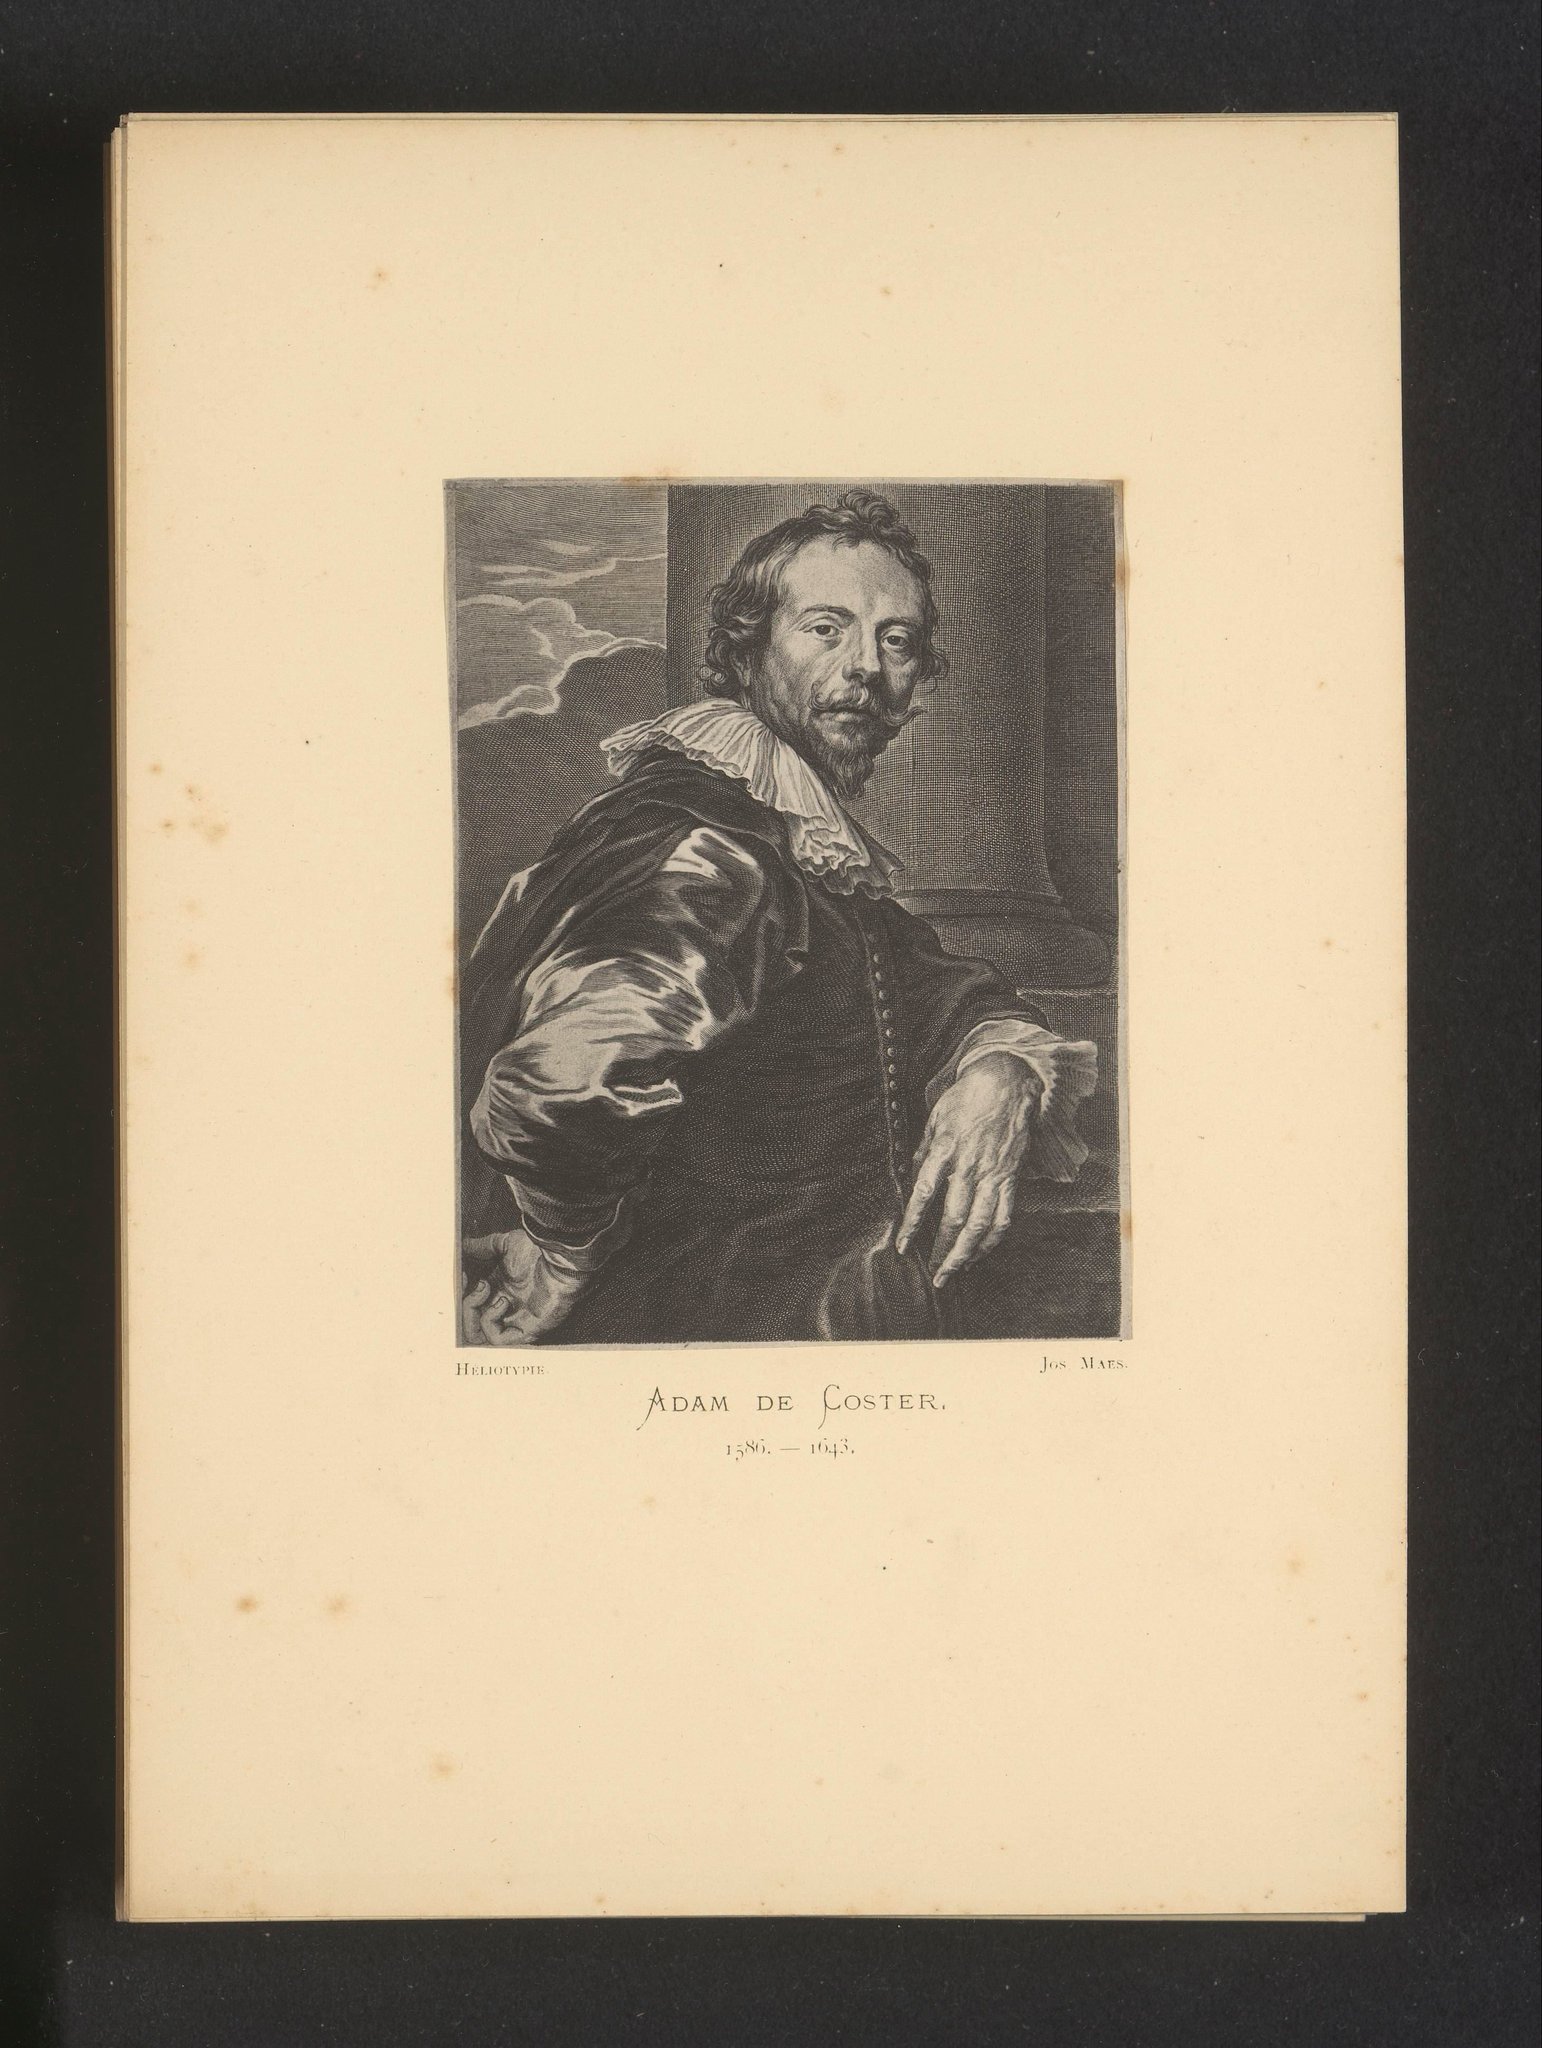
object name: reproduction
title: Reproductie van een gravure van een portret van Adam de Coster door Pieter de Jode (II)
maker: joseph maes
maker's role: fotograaf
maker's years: 1838-1908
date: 1872-1877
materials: cardboard, paper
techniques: photograph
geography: antwerp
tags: antwerp, painter, adam de coster, historical persons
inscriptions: inscription: ‘1586. - 1643.’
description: Deze prent maakt deel uit van een omslag met 150 prenten en een katern met een lijst van afbeeldingen.